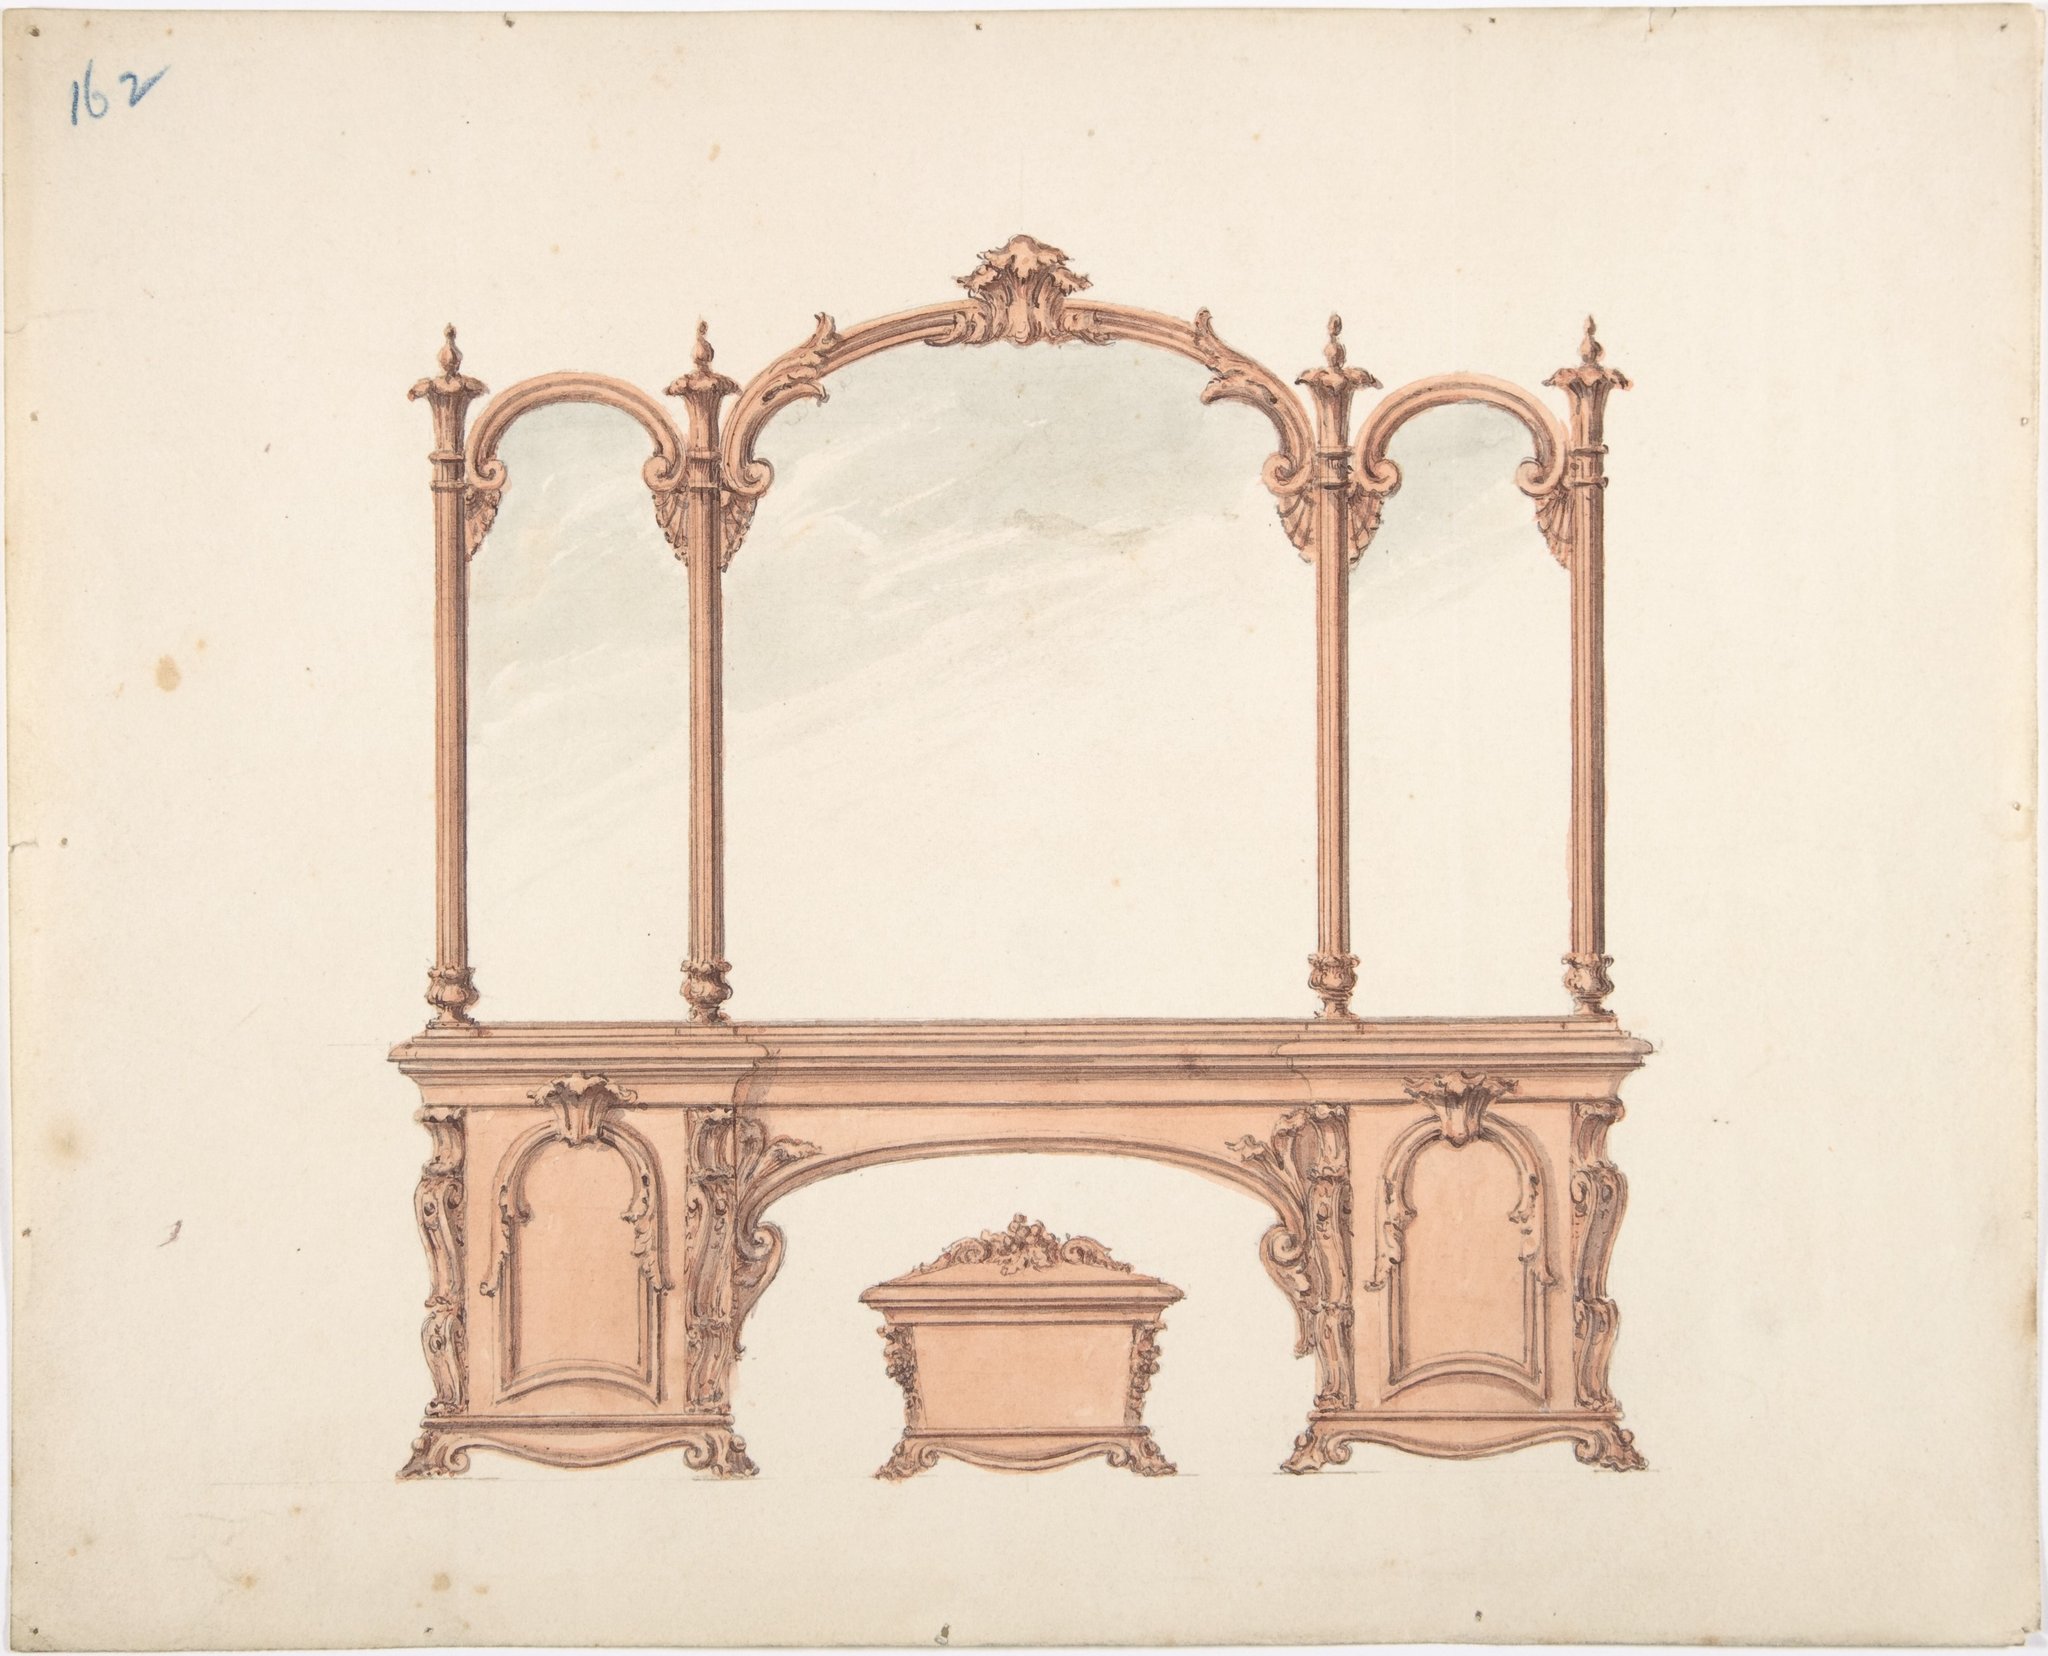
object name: drawing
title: Design for a Mirrored Sideboard with Rococo Ornament, and Casket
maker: anonymous, british, 19th century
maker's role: artist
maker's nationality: british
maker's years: 1800-1900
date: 1801-1833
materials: ink, watercolor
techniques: pen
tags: furniture,mirrors